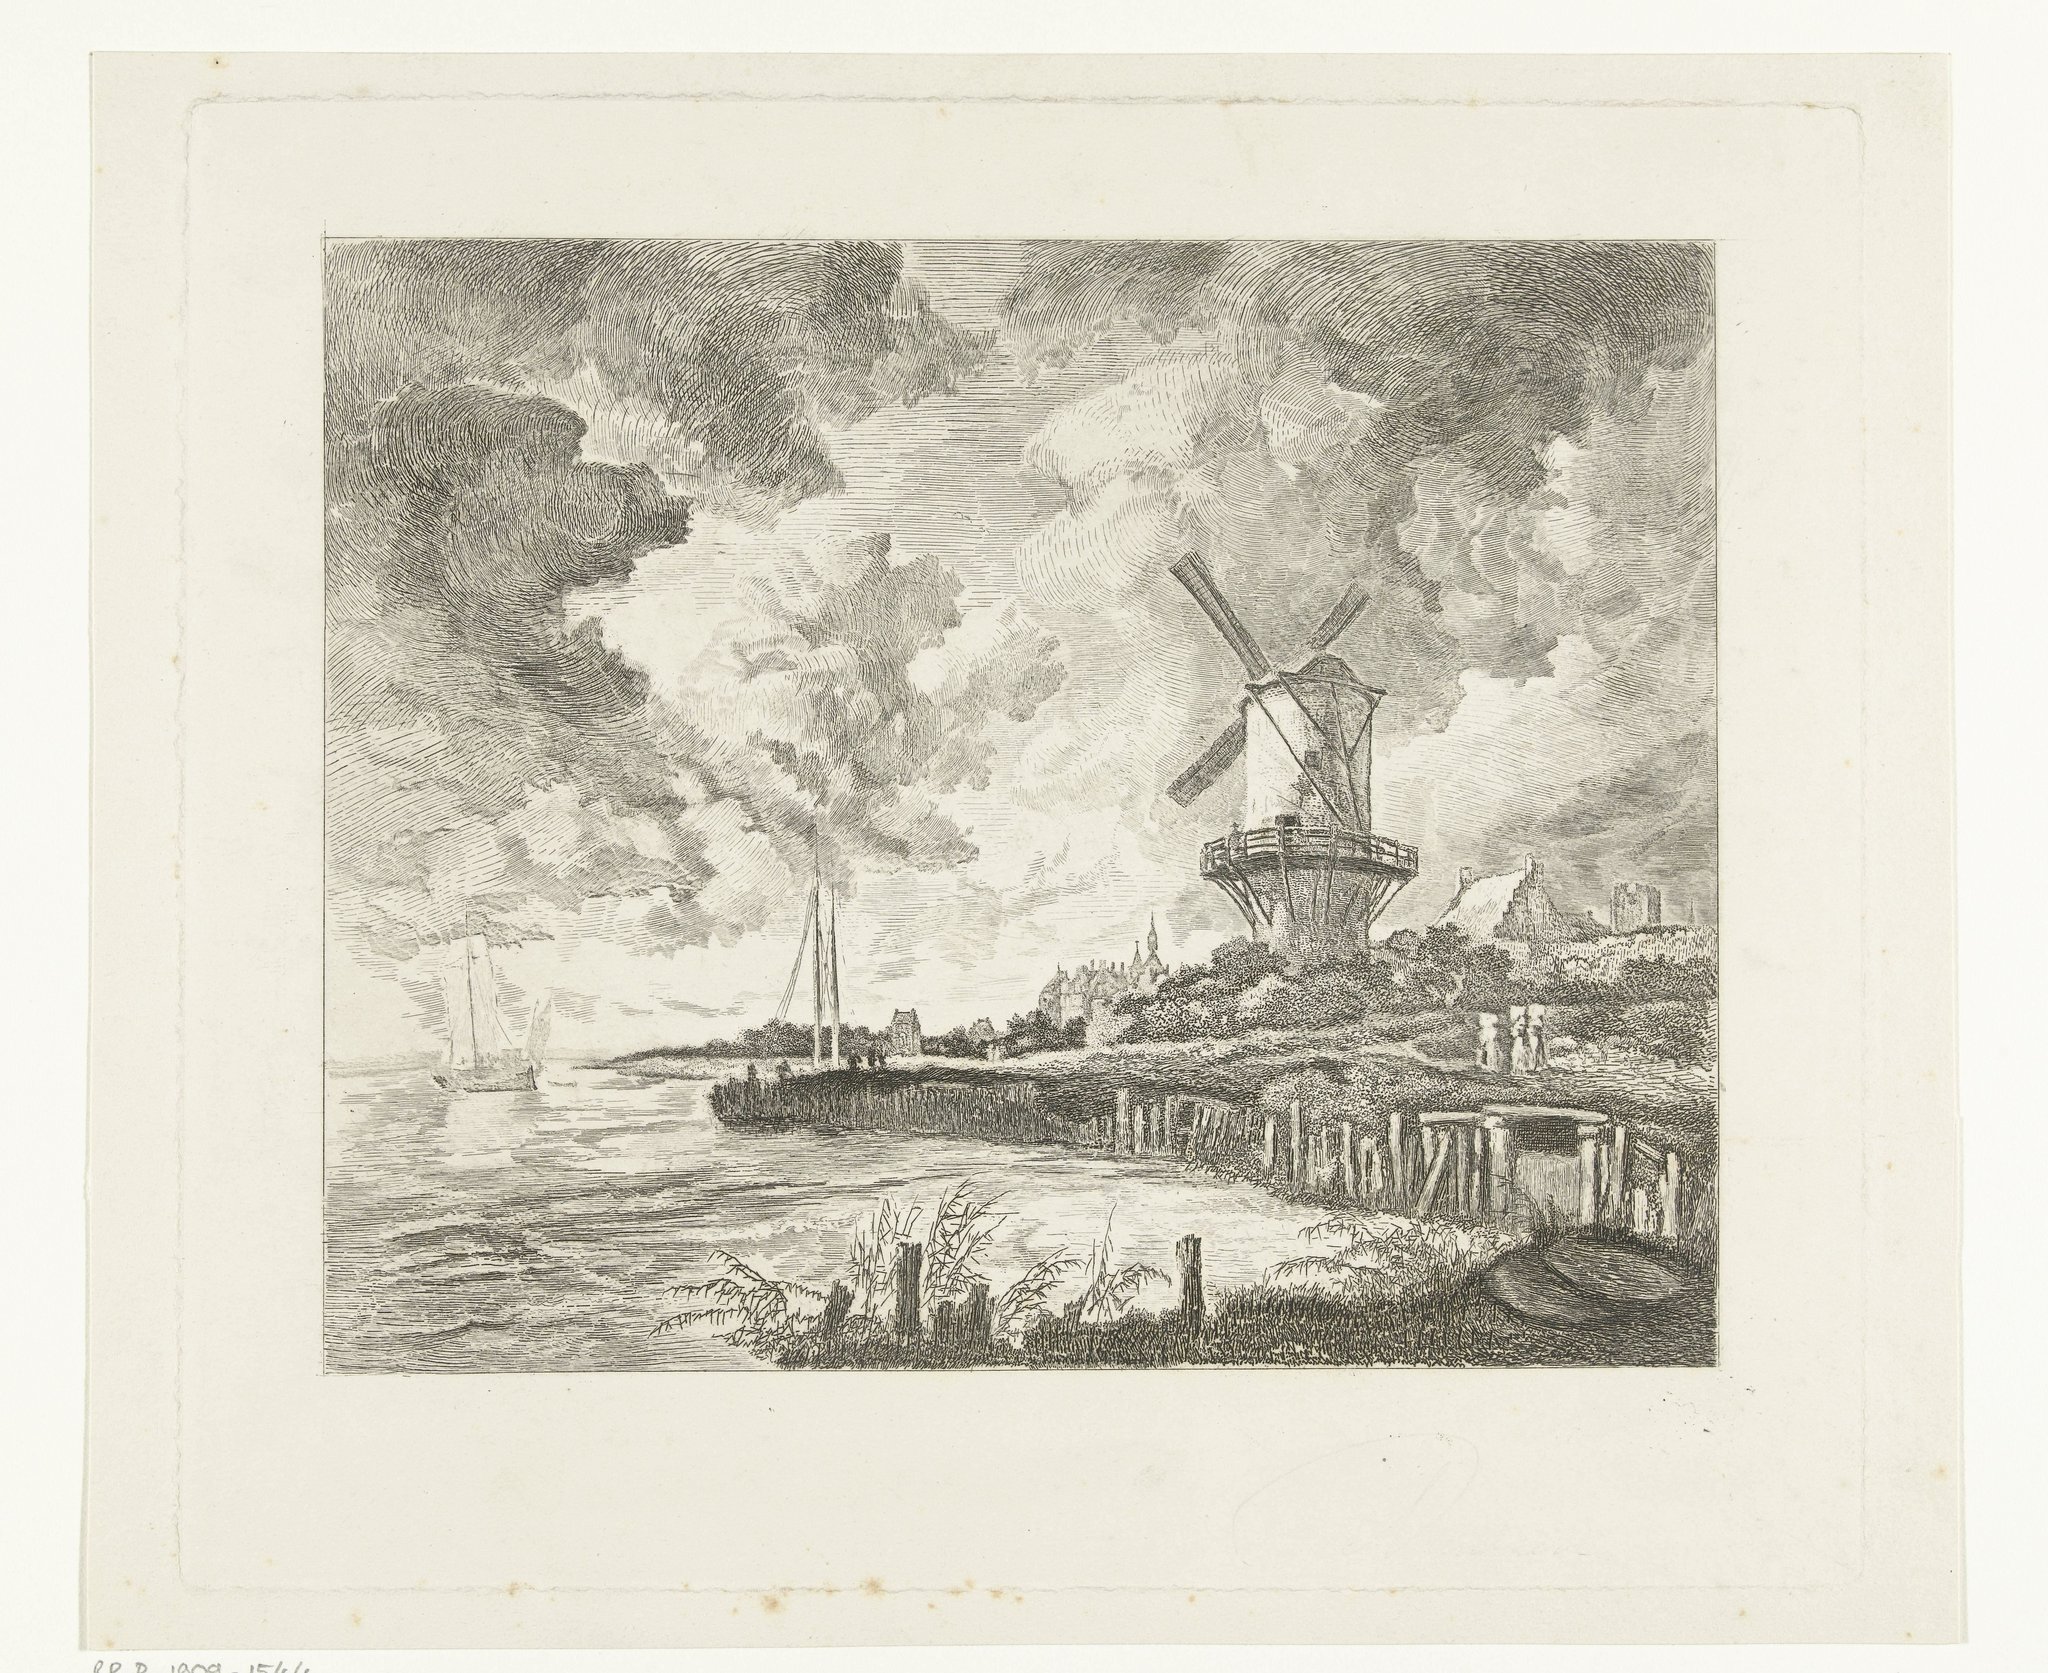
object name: print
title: Molen bij Wijk bij Duurstede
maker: johannes arnoldus boland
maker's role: print maker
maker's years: 1838-1922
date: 1860-1900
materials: paper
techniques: etching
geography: amsterdam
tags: windmill in landscape, wijk bij duurstede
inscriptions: collector's mark: Lugt 2228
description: Coll. de la Faille. Reproductie van een schilderij uit de collectie van het RMA, SK-C-211.